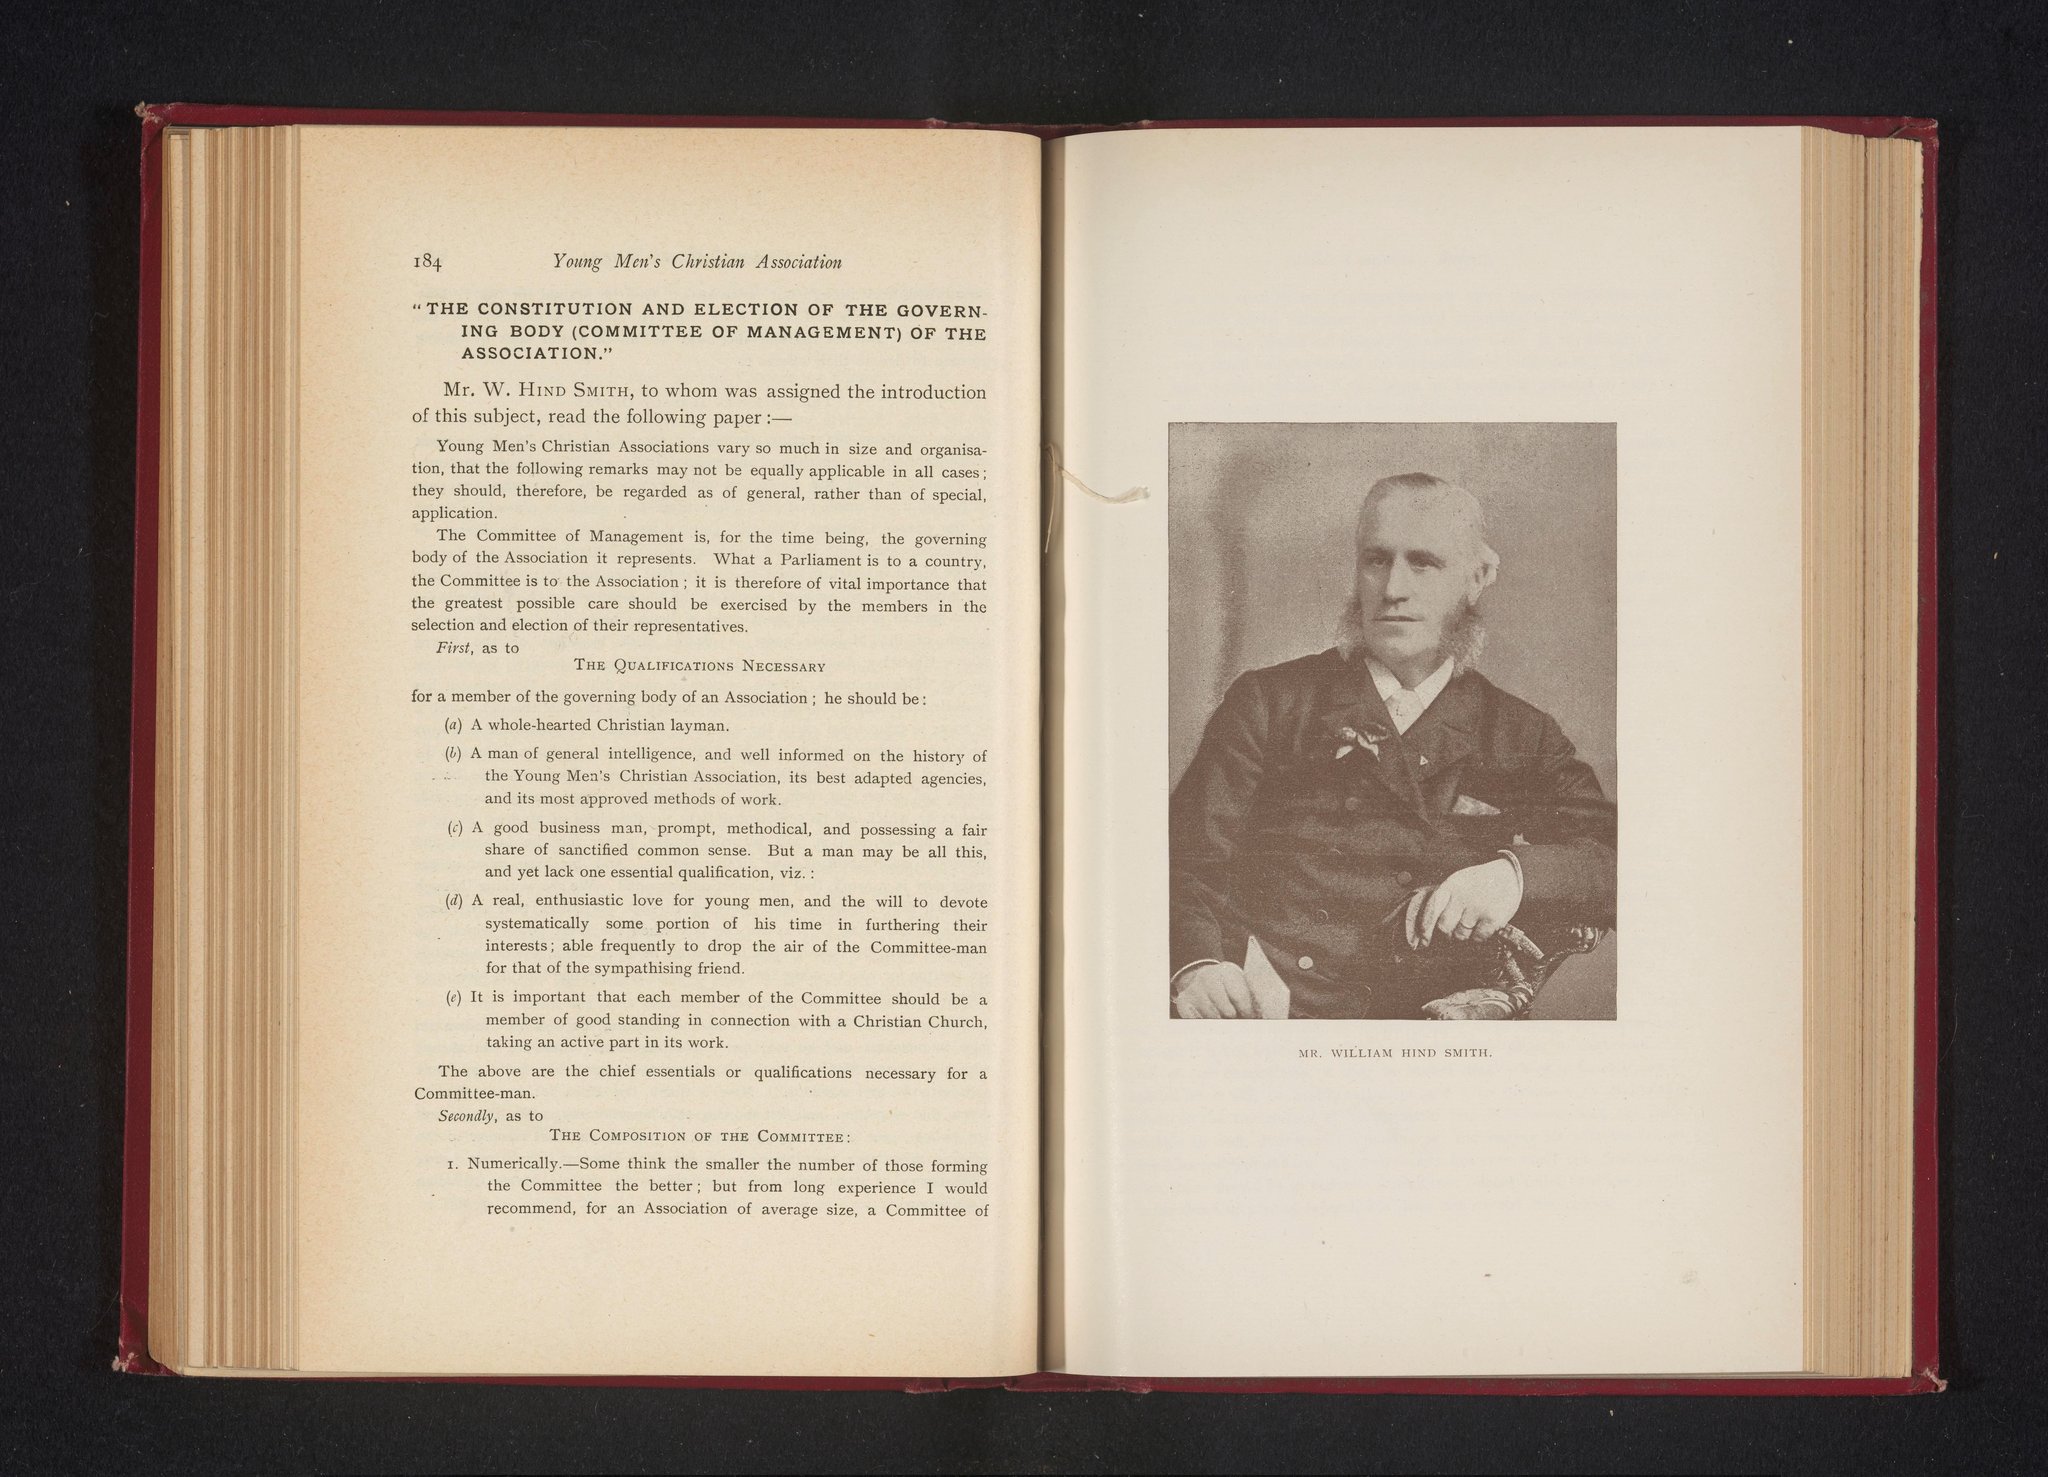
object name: photomechanical print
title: Mr. William Hind Smith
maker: Anonymous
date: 1890-1895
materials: paper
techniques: autotype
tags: historical persons